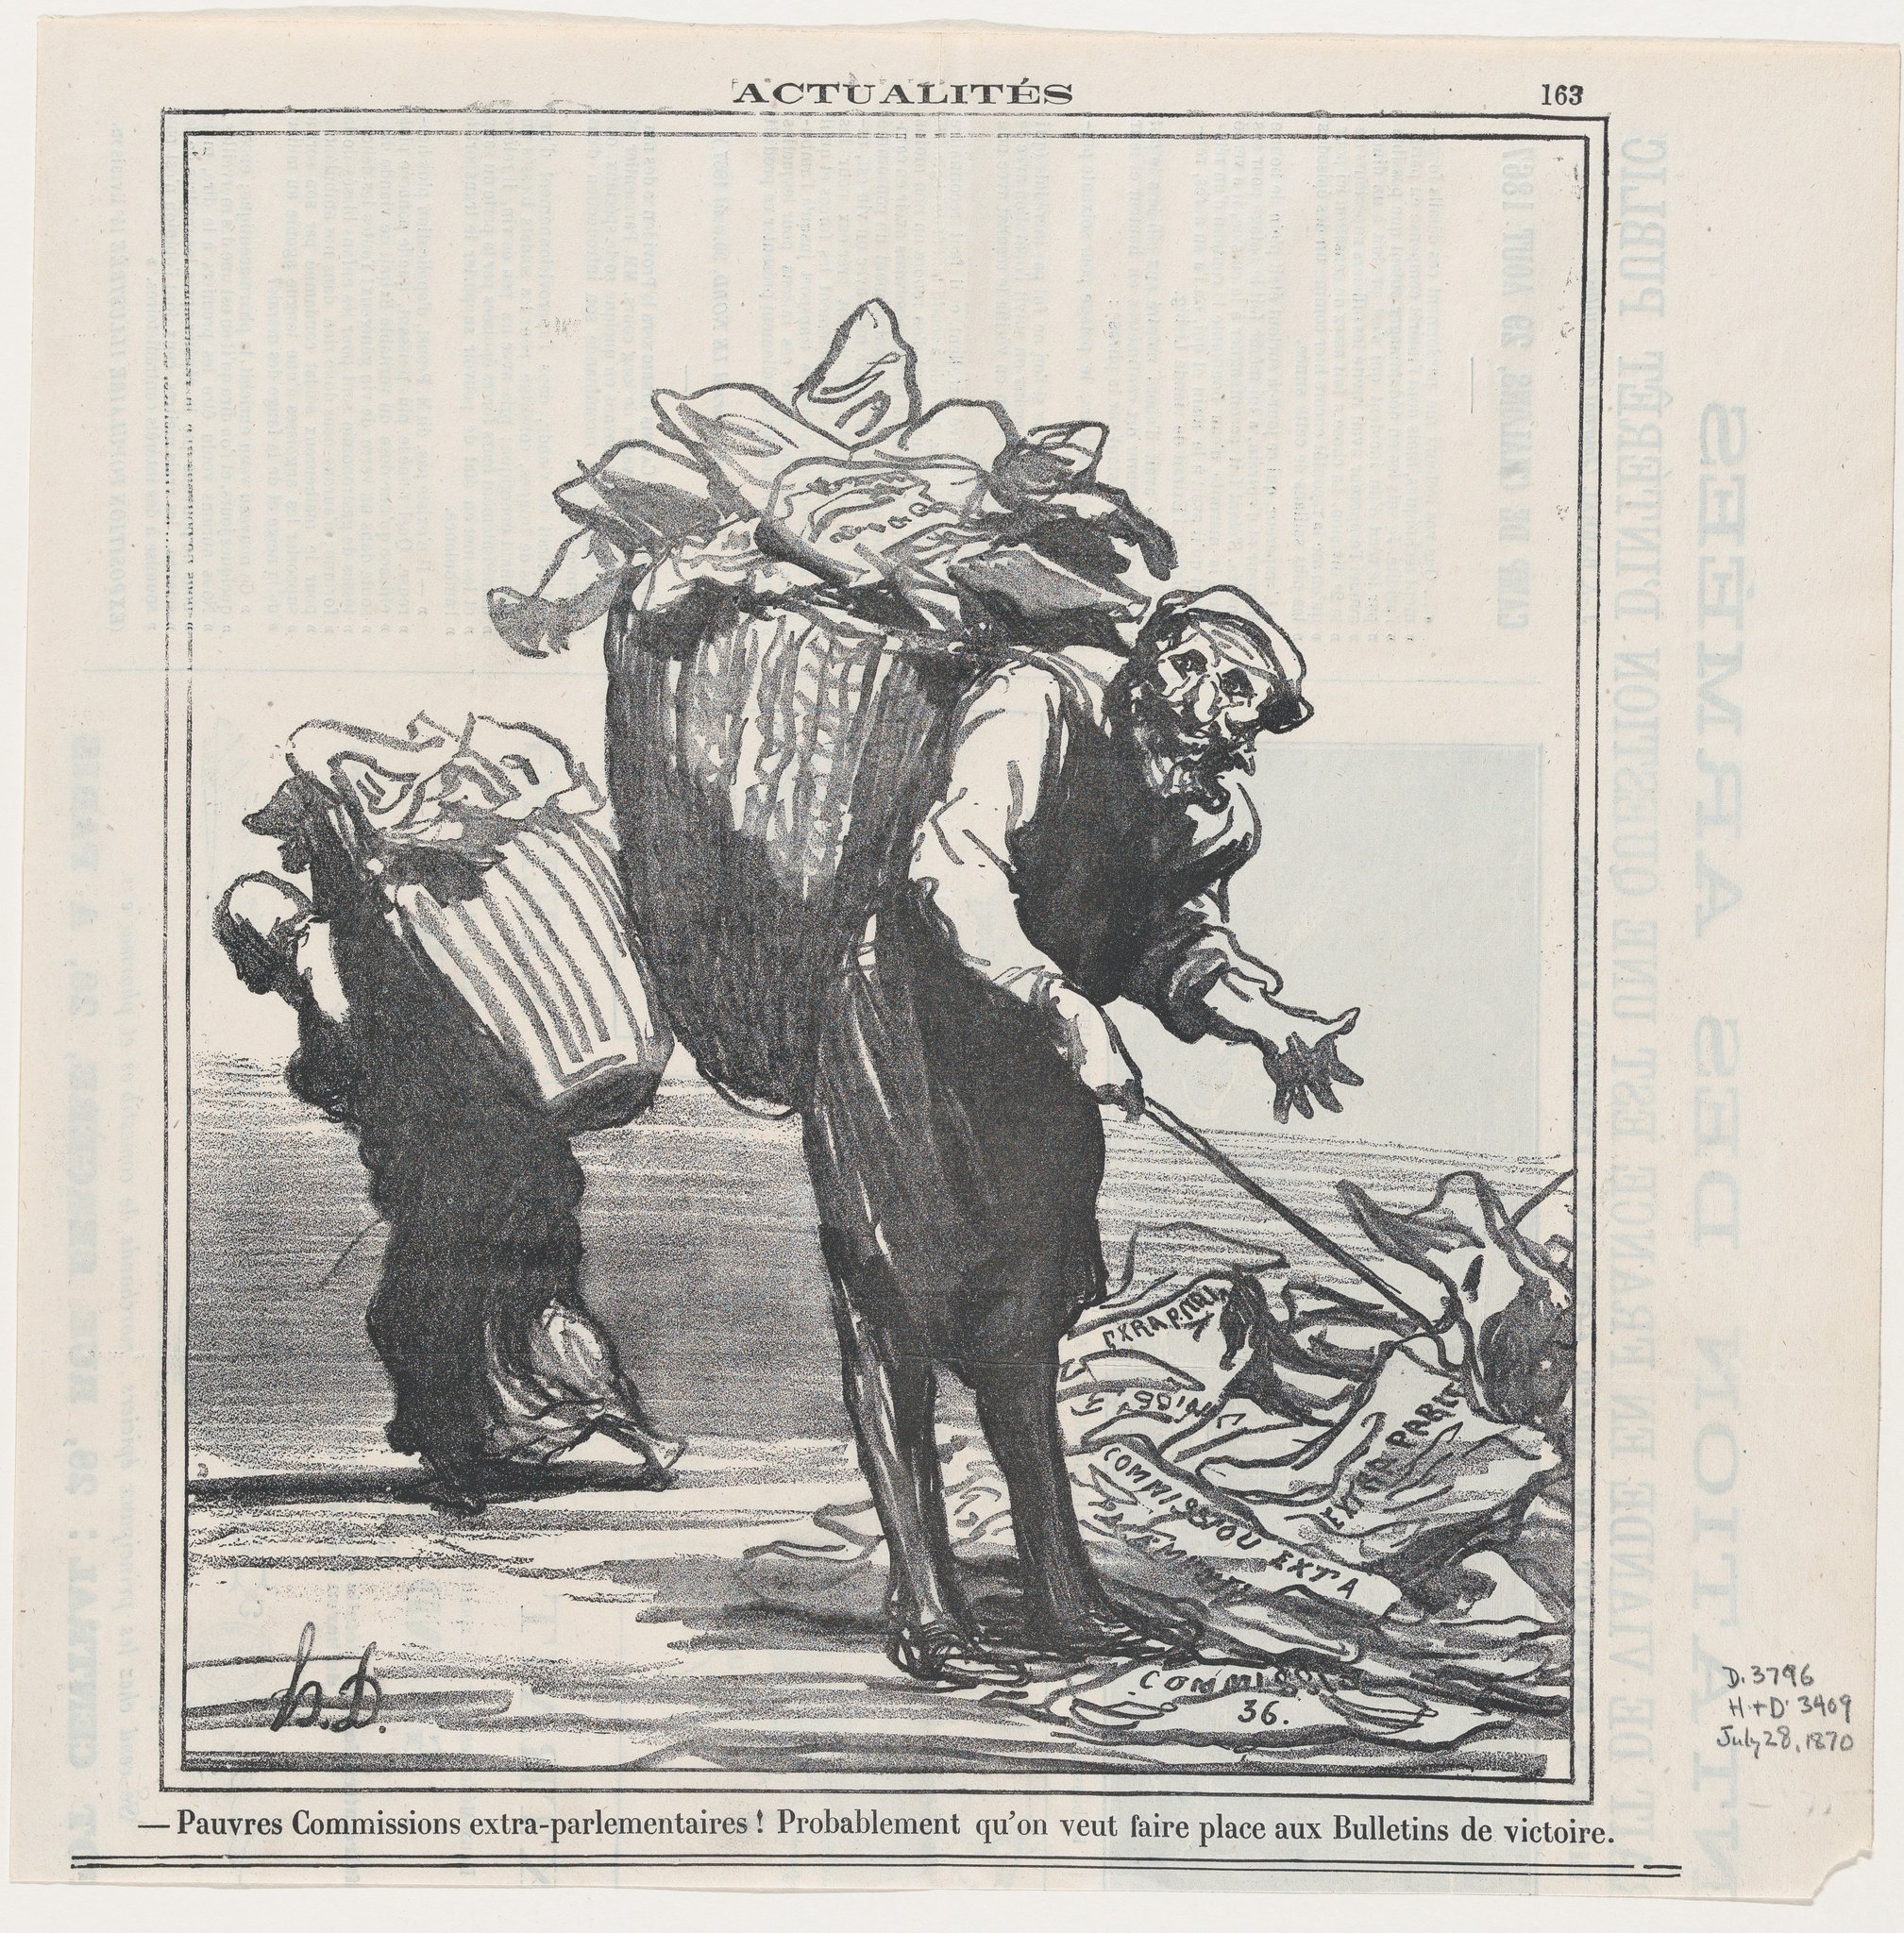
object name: print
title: Poor extra parliamentary commission! They probably just wanted to make room for some victory bulletins, from 'News of the day,' published in Le Charivari, July 28, 1870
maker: honoré daumier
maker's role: artist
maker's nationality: french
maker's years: 1808-1879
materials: paper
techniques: lithograph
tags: men,working